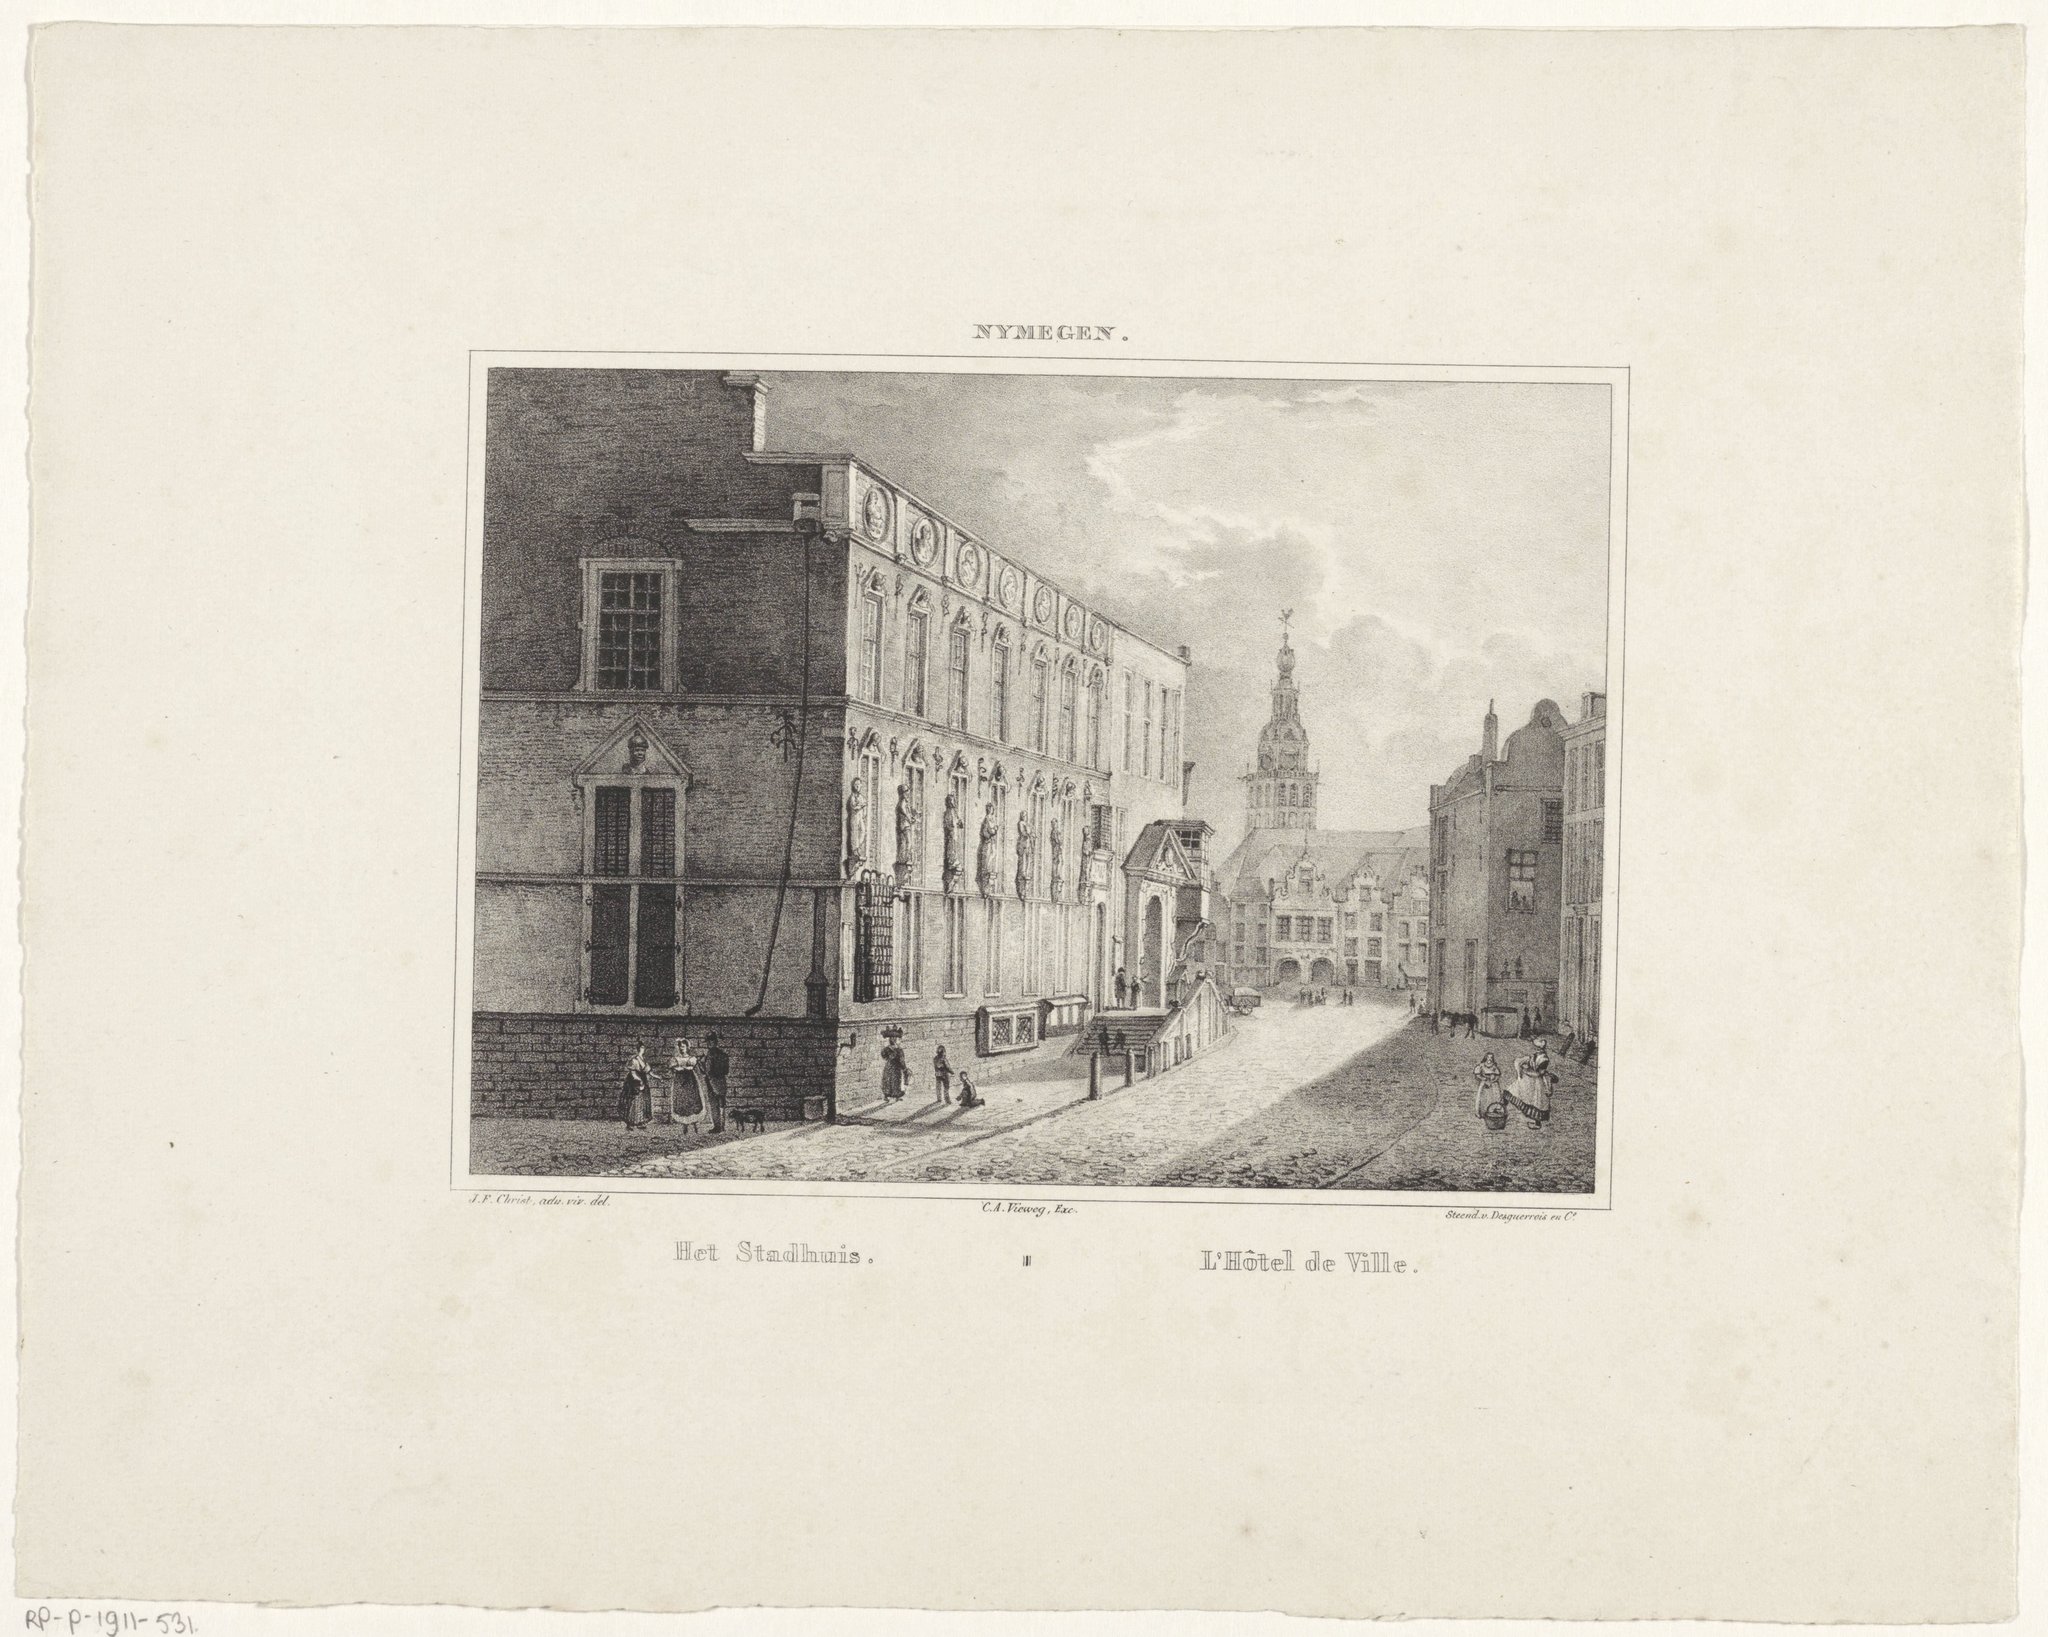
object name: print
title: Stadhuis van Nijmegen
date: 1834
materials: paper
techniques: lithograph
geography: nijmegen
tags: townhall, parts of church exterior and annexes: tower, nijmegen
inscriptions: collector's mark: Lugt 2228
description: Links aan de straat staat het stadhuis met een gevel in vroegerenaissance stijl. Voor de ingang staan twee figuren. In de verte, achter de huizen, de toren van de Stevenskerk.